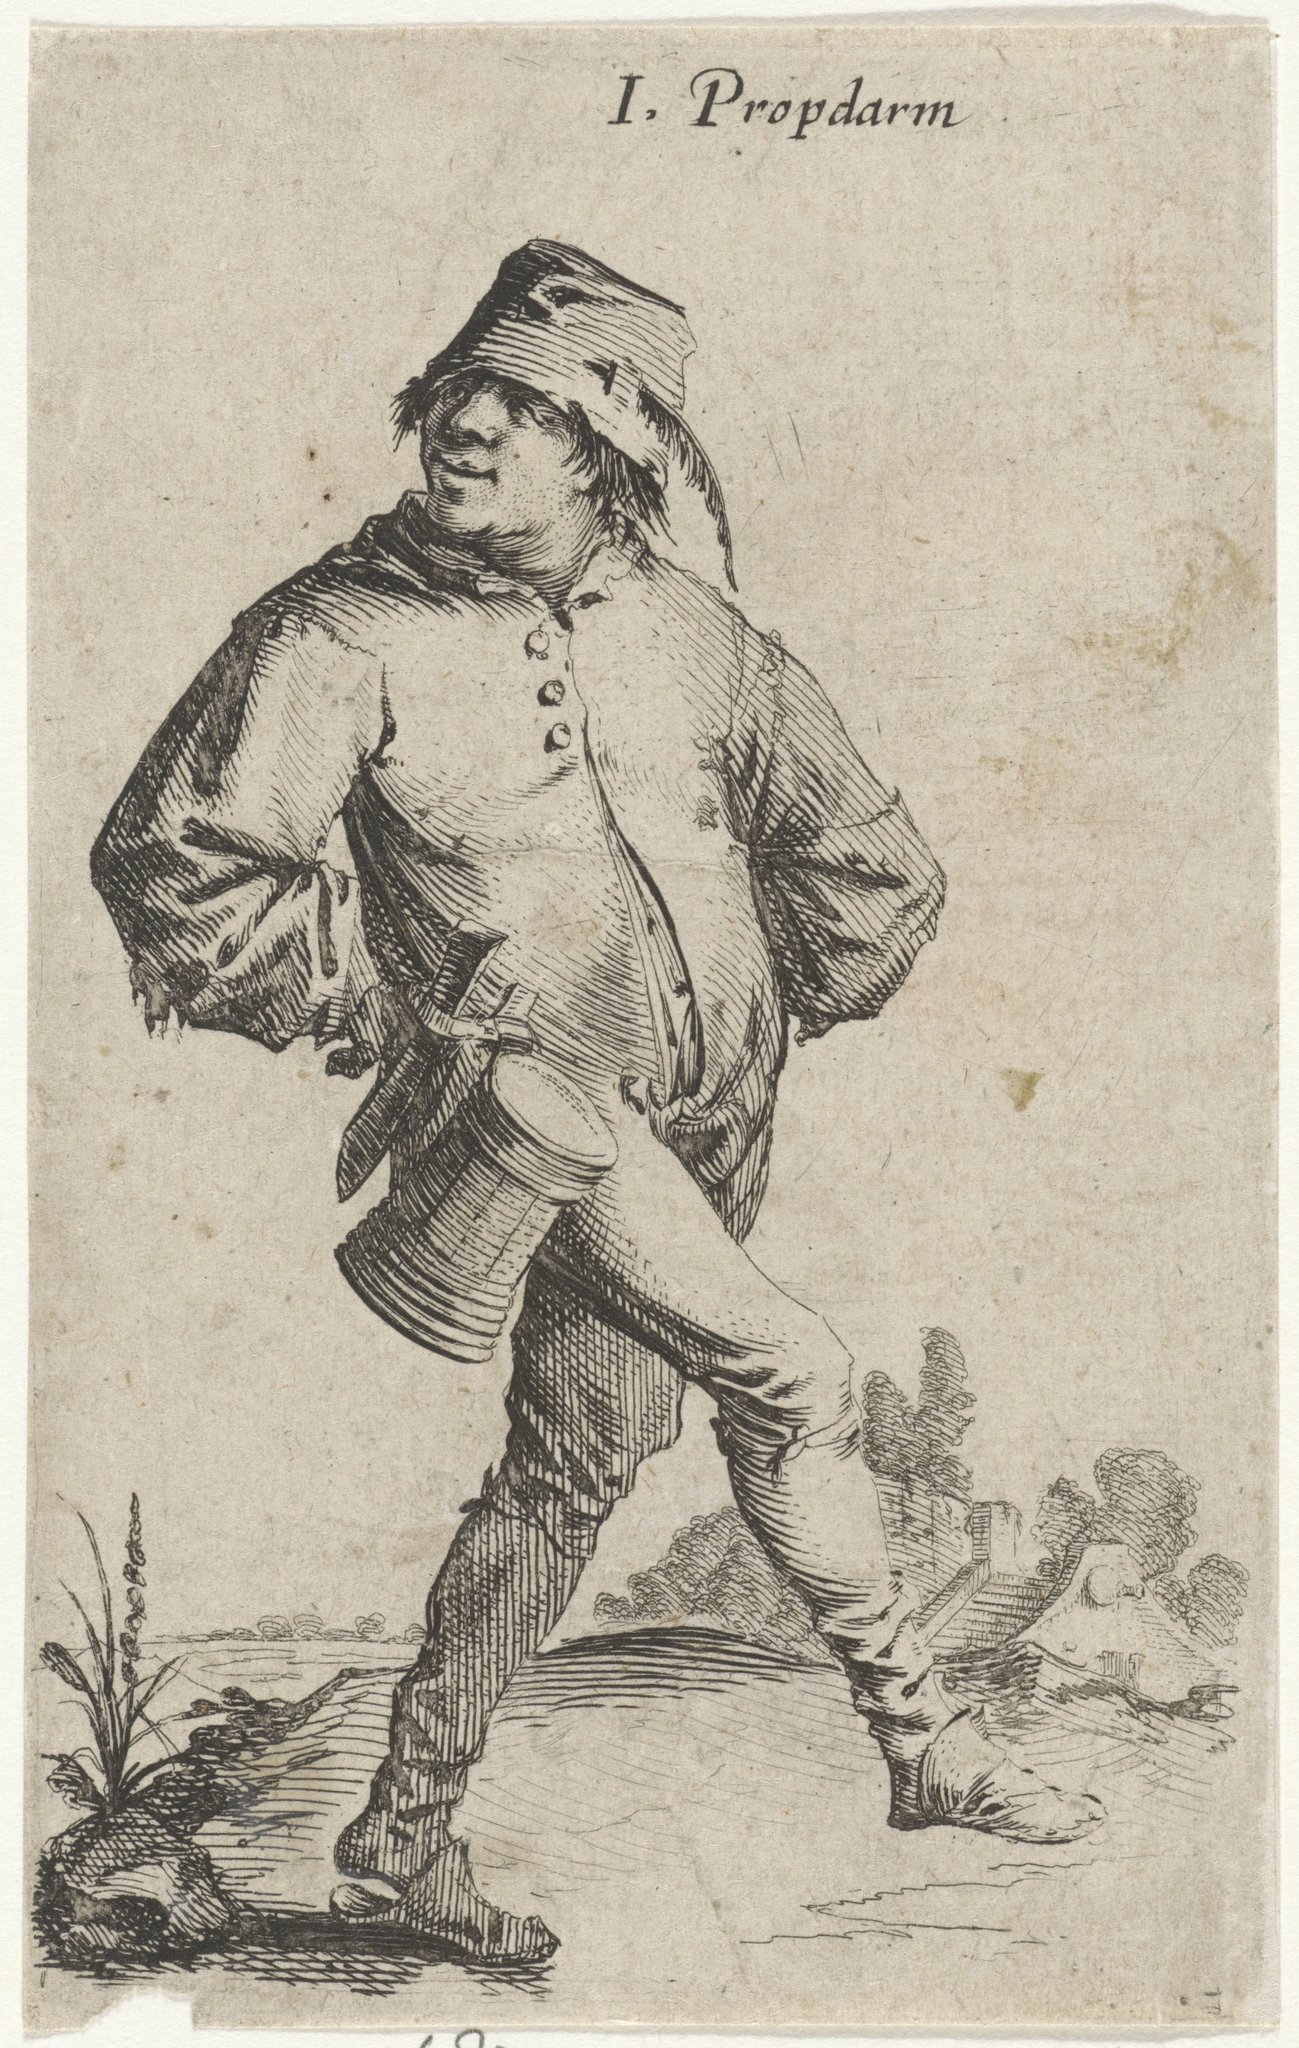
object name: print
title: T'Leven Der Boeren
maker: salomon savery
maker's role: print maker, publisher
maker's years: 1594-1683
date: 1630-1665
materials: paper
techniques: engraving, etching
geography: amsterdam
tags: hacking and thrusting weapons: dagger, farmers, drinking-vessels, man dancing alone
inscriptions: collector's mark: Lugt 2228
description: Zie tevens de vijf overgeleverde spiegelbeeldige kopieën naar deze serie door Reinhard Voskens.